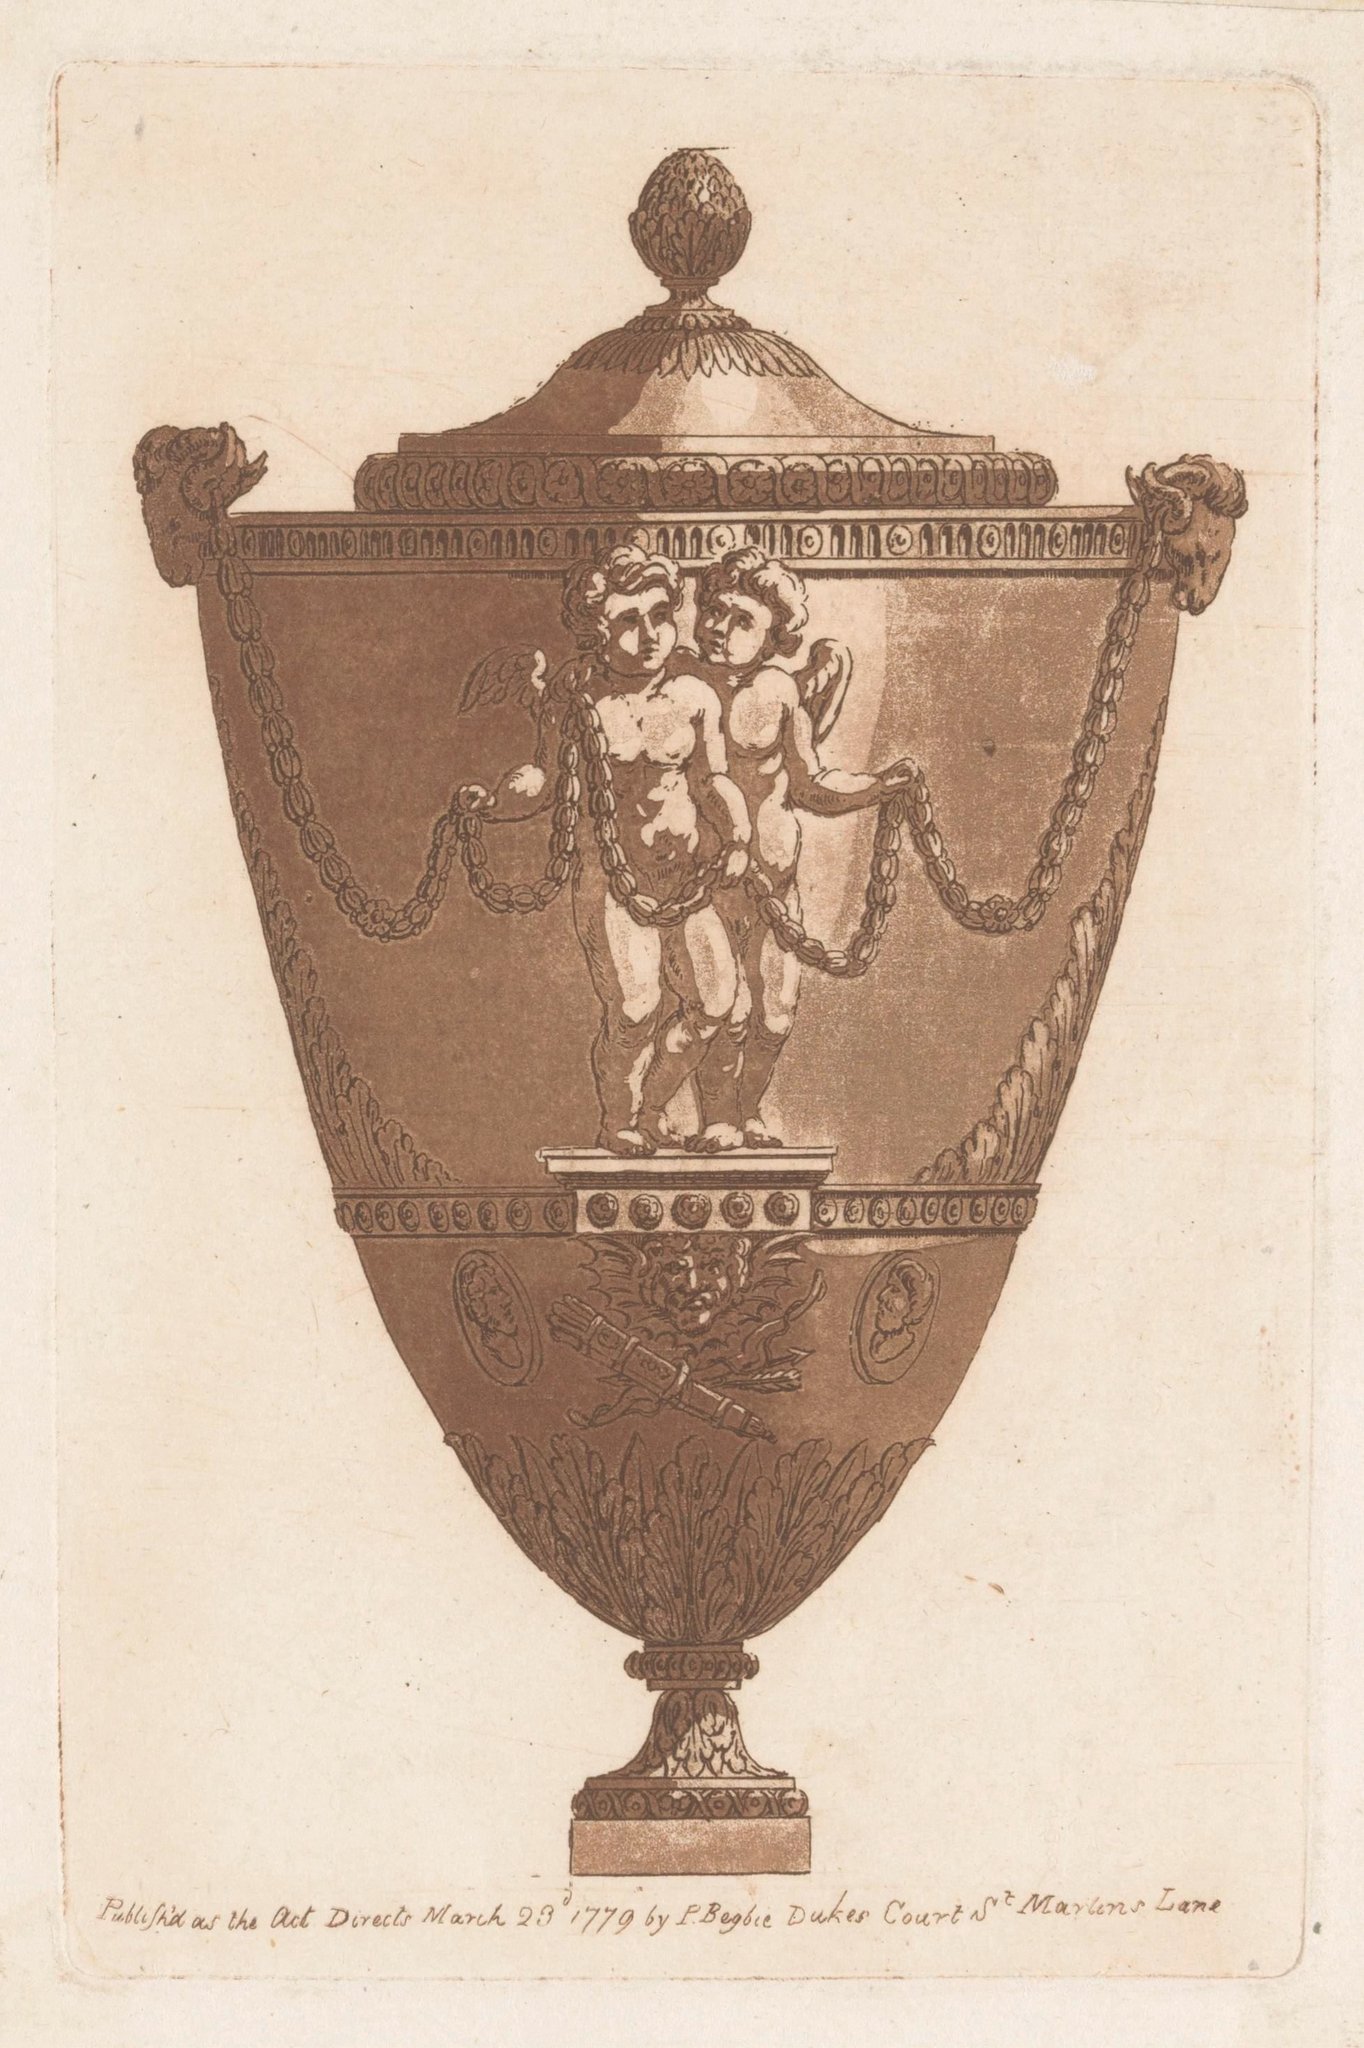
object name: print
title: Vases after the manner of the Antique (...)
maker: patrick begbie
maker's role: print maker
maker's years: -1820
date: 1779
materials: paper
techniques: aquatint, etching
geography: london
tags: vase ~ ornament, cupids: 'amores', 'amoretti', 'putti'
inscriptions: collector's mark: Lugt 2228, collector's mark: Lugt 2760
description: Een antieke geornamenteerde vaas met twee putti met guirlandes.